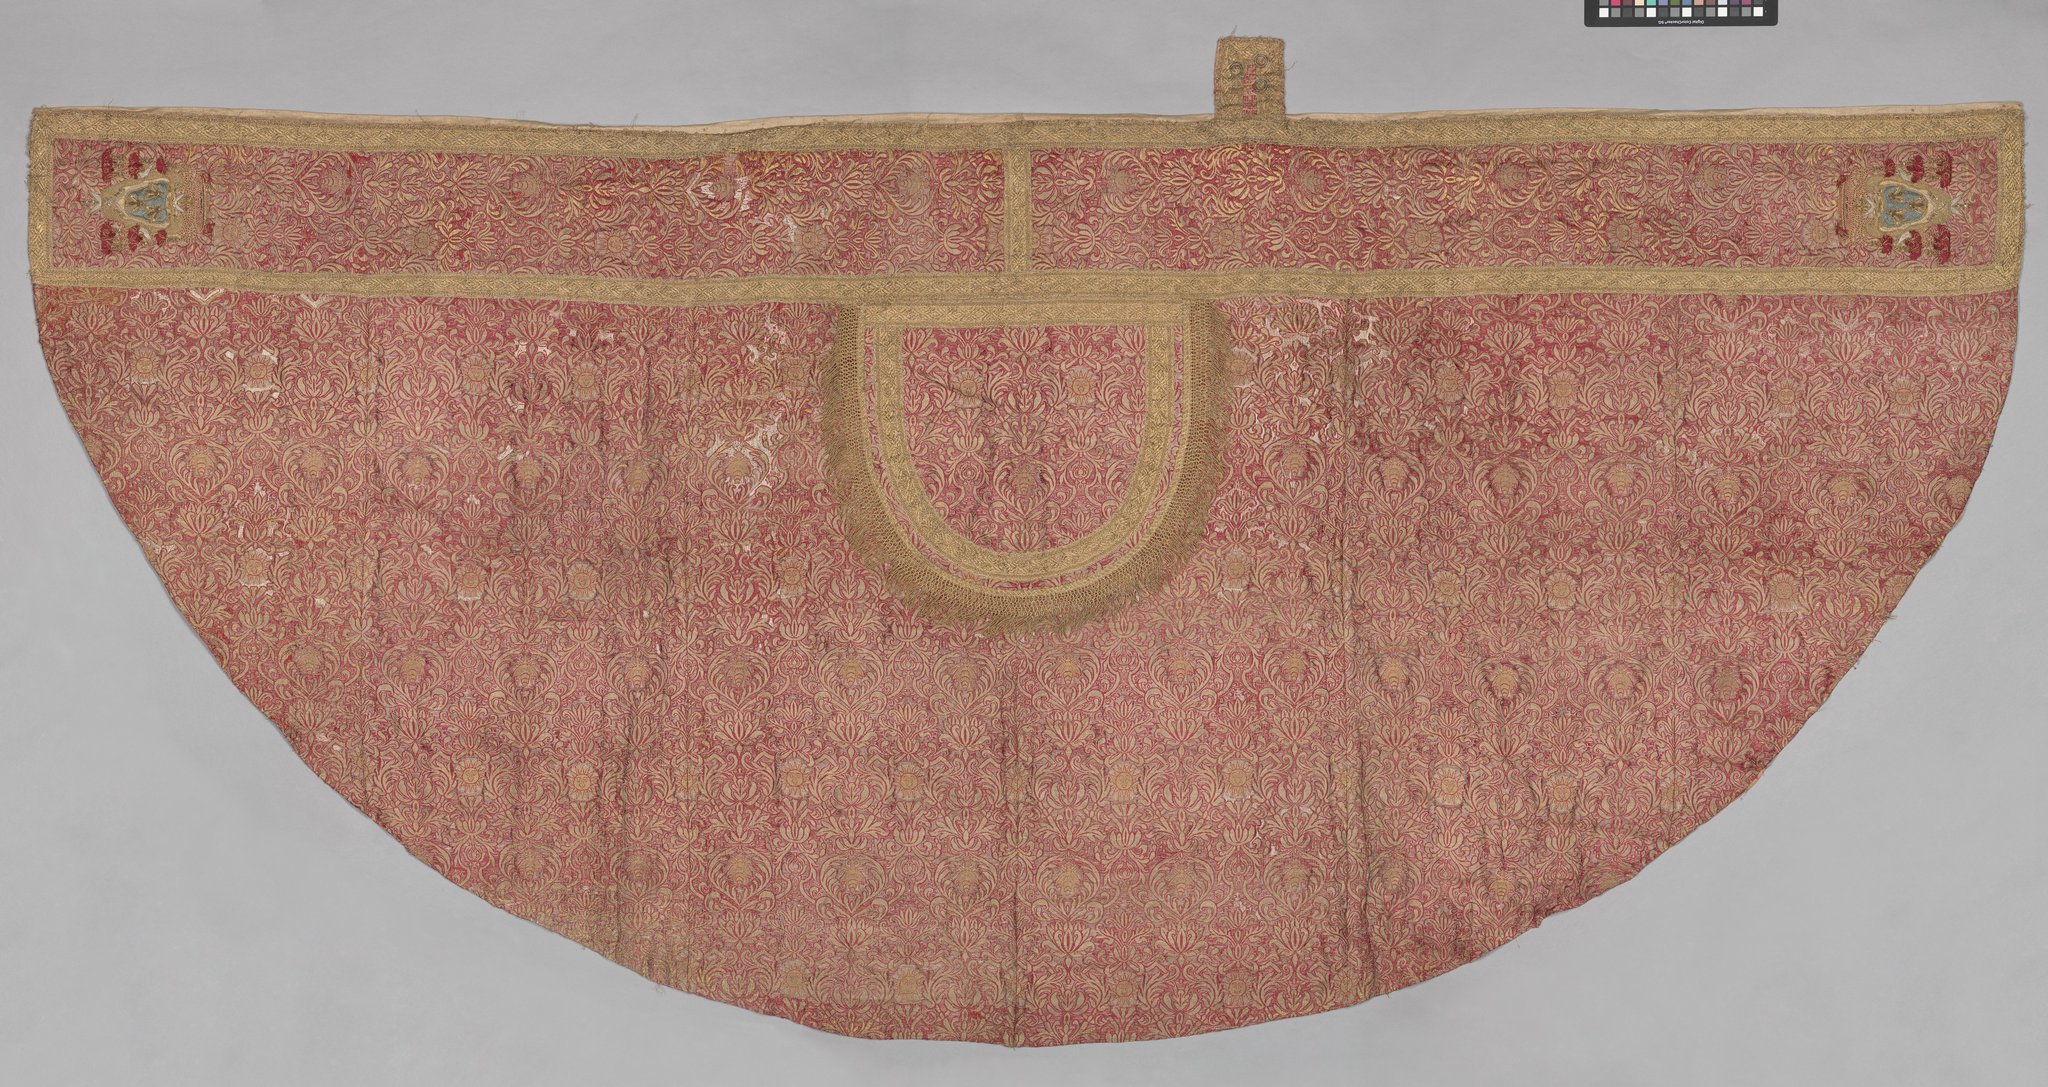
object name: cope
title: Cope made for Antonio Barberini (1607-1671), Grand Prior of Rome in the Order of Saint John and the Knights of Malta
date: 1623-1628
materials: gold, metal thread, silk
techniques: embroidery, lampas, weave